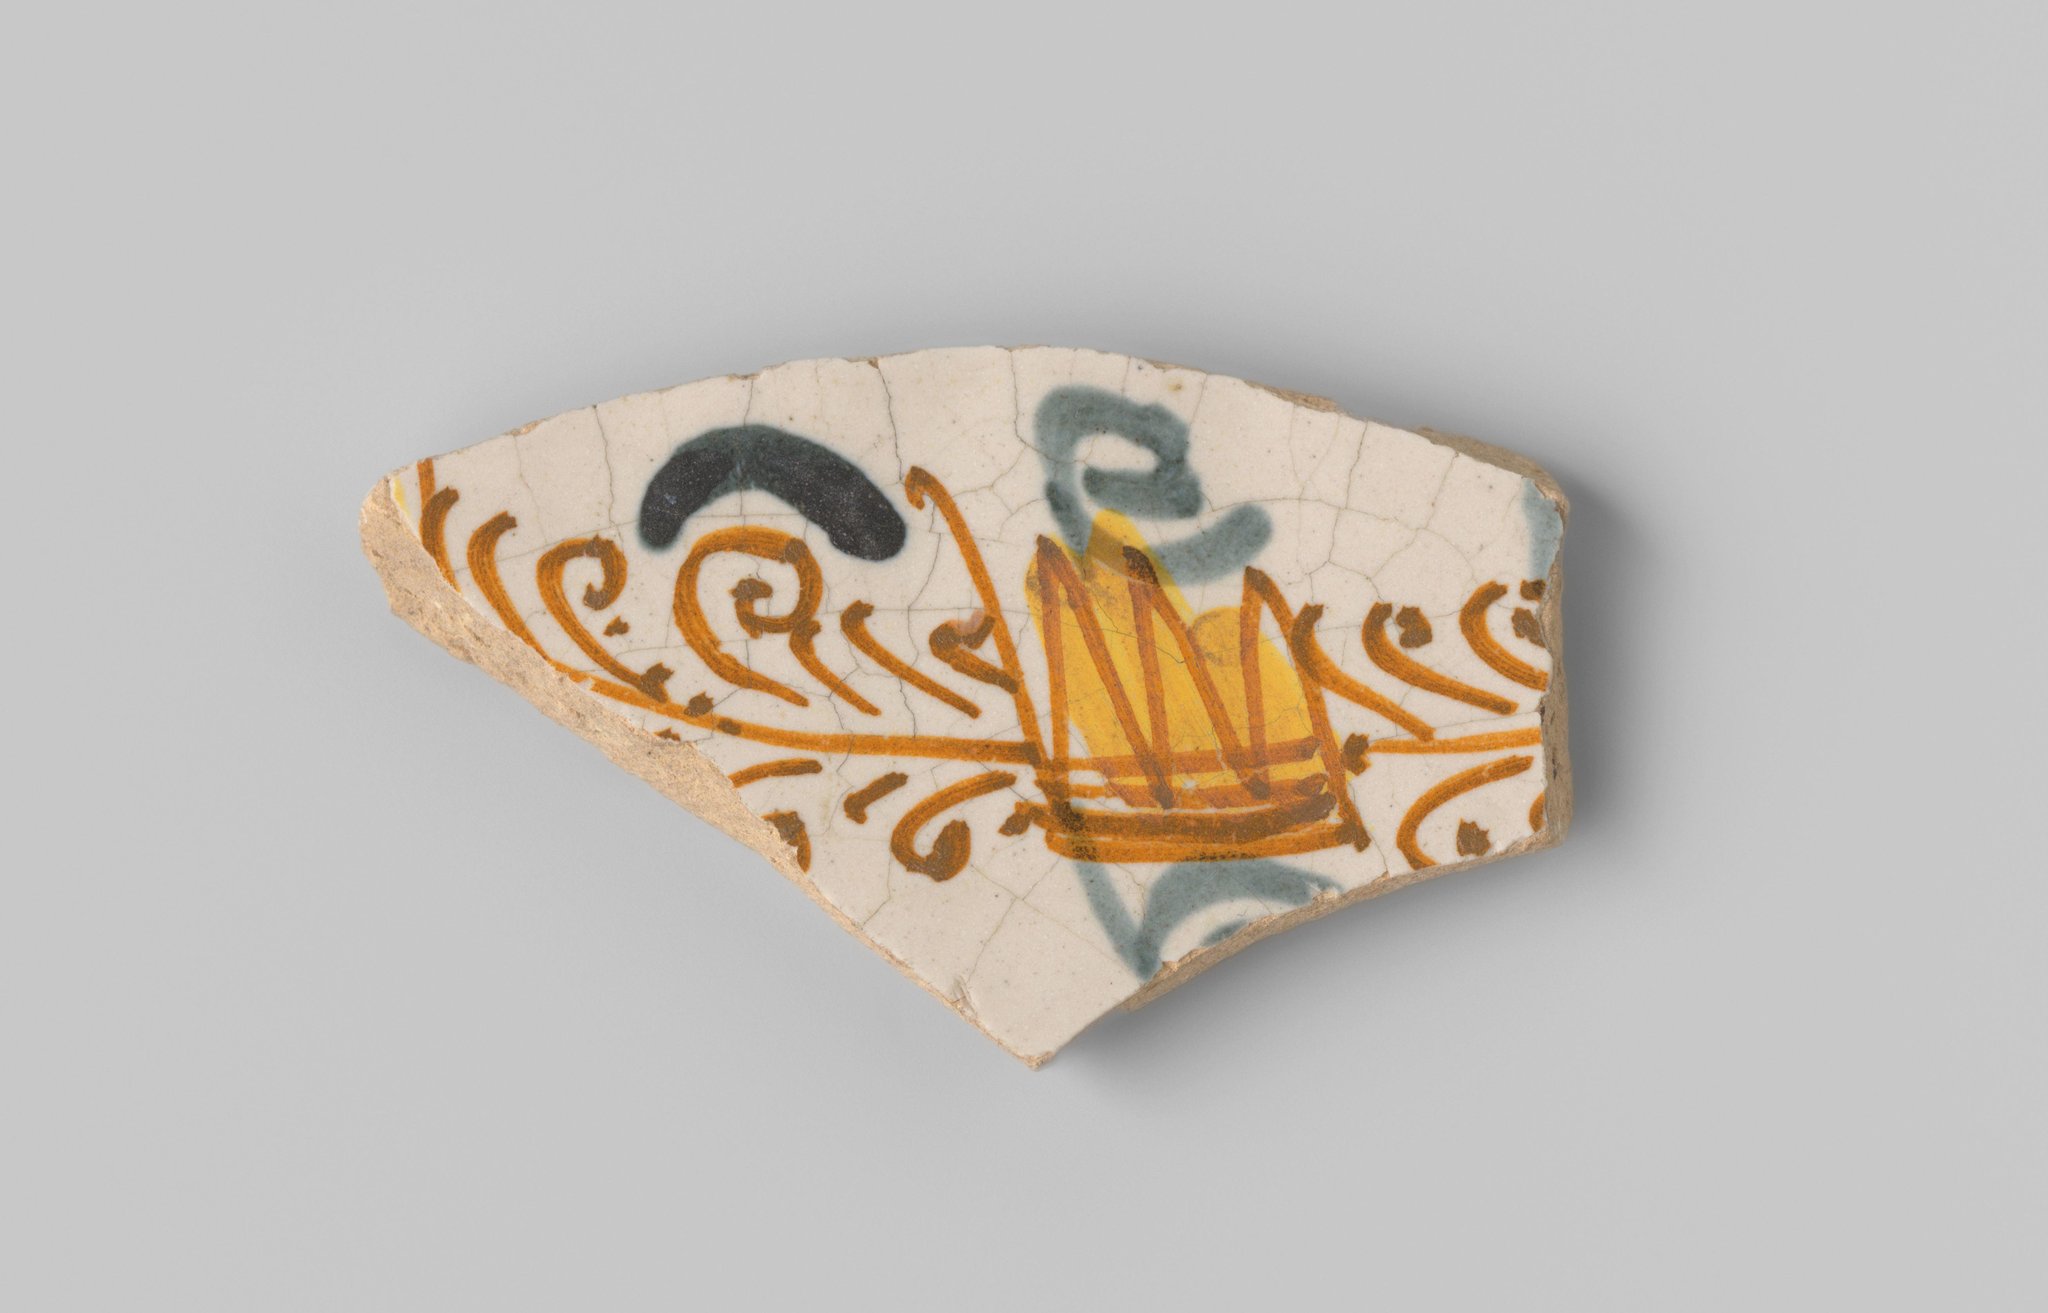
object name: sherd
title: Fragment van een schotel met rossigbakkende scherf, met aan de voor- en achterzijde zijde wit glazuur, waarop aan de voorzijde in geel, oranje, licht- en donkerblauw strepen en krullen zijn beschilderd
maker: Anonymous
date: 1200-1899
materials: earthenware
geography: italy